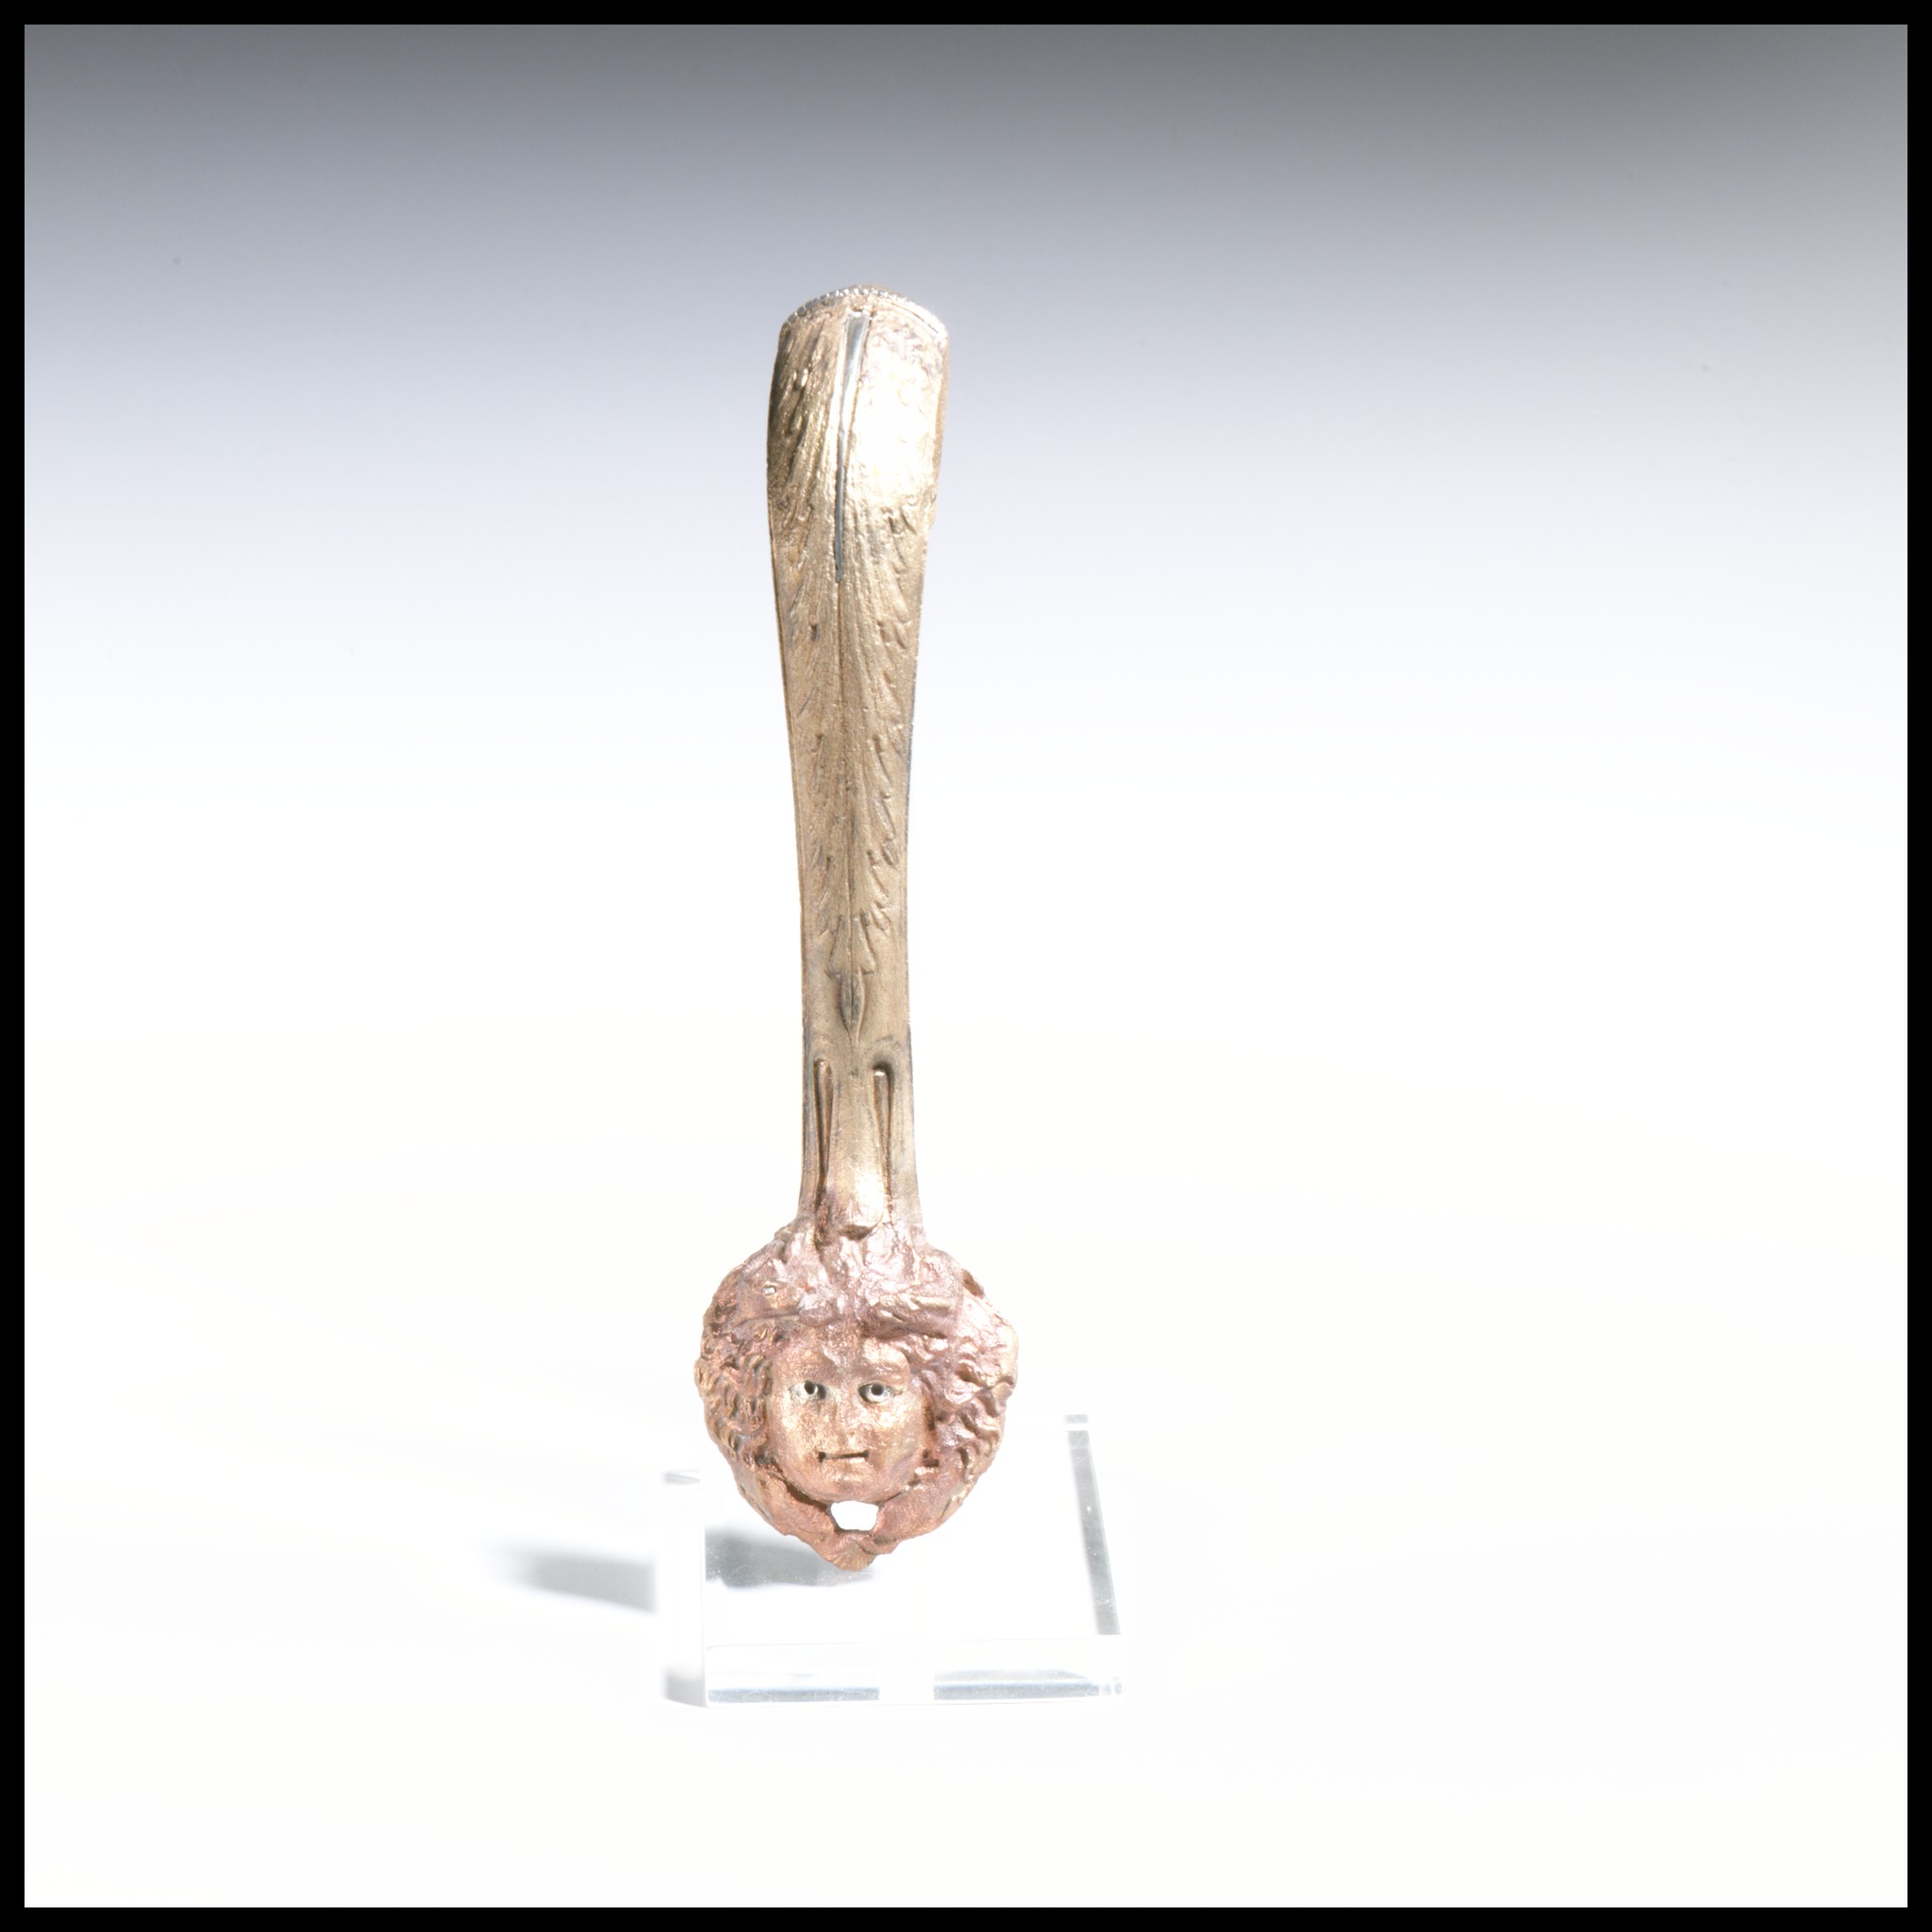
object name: handle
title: Bronze jug handle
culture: roman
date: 1-200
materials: bronze, silver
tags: medusa,leaves